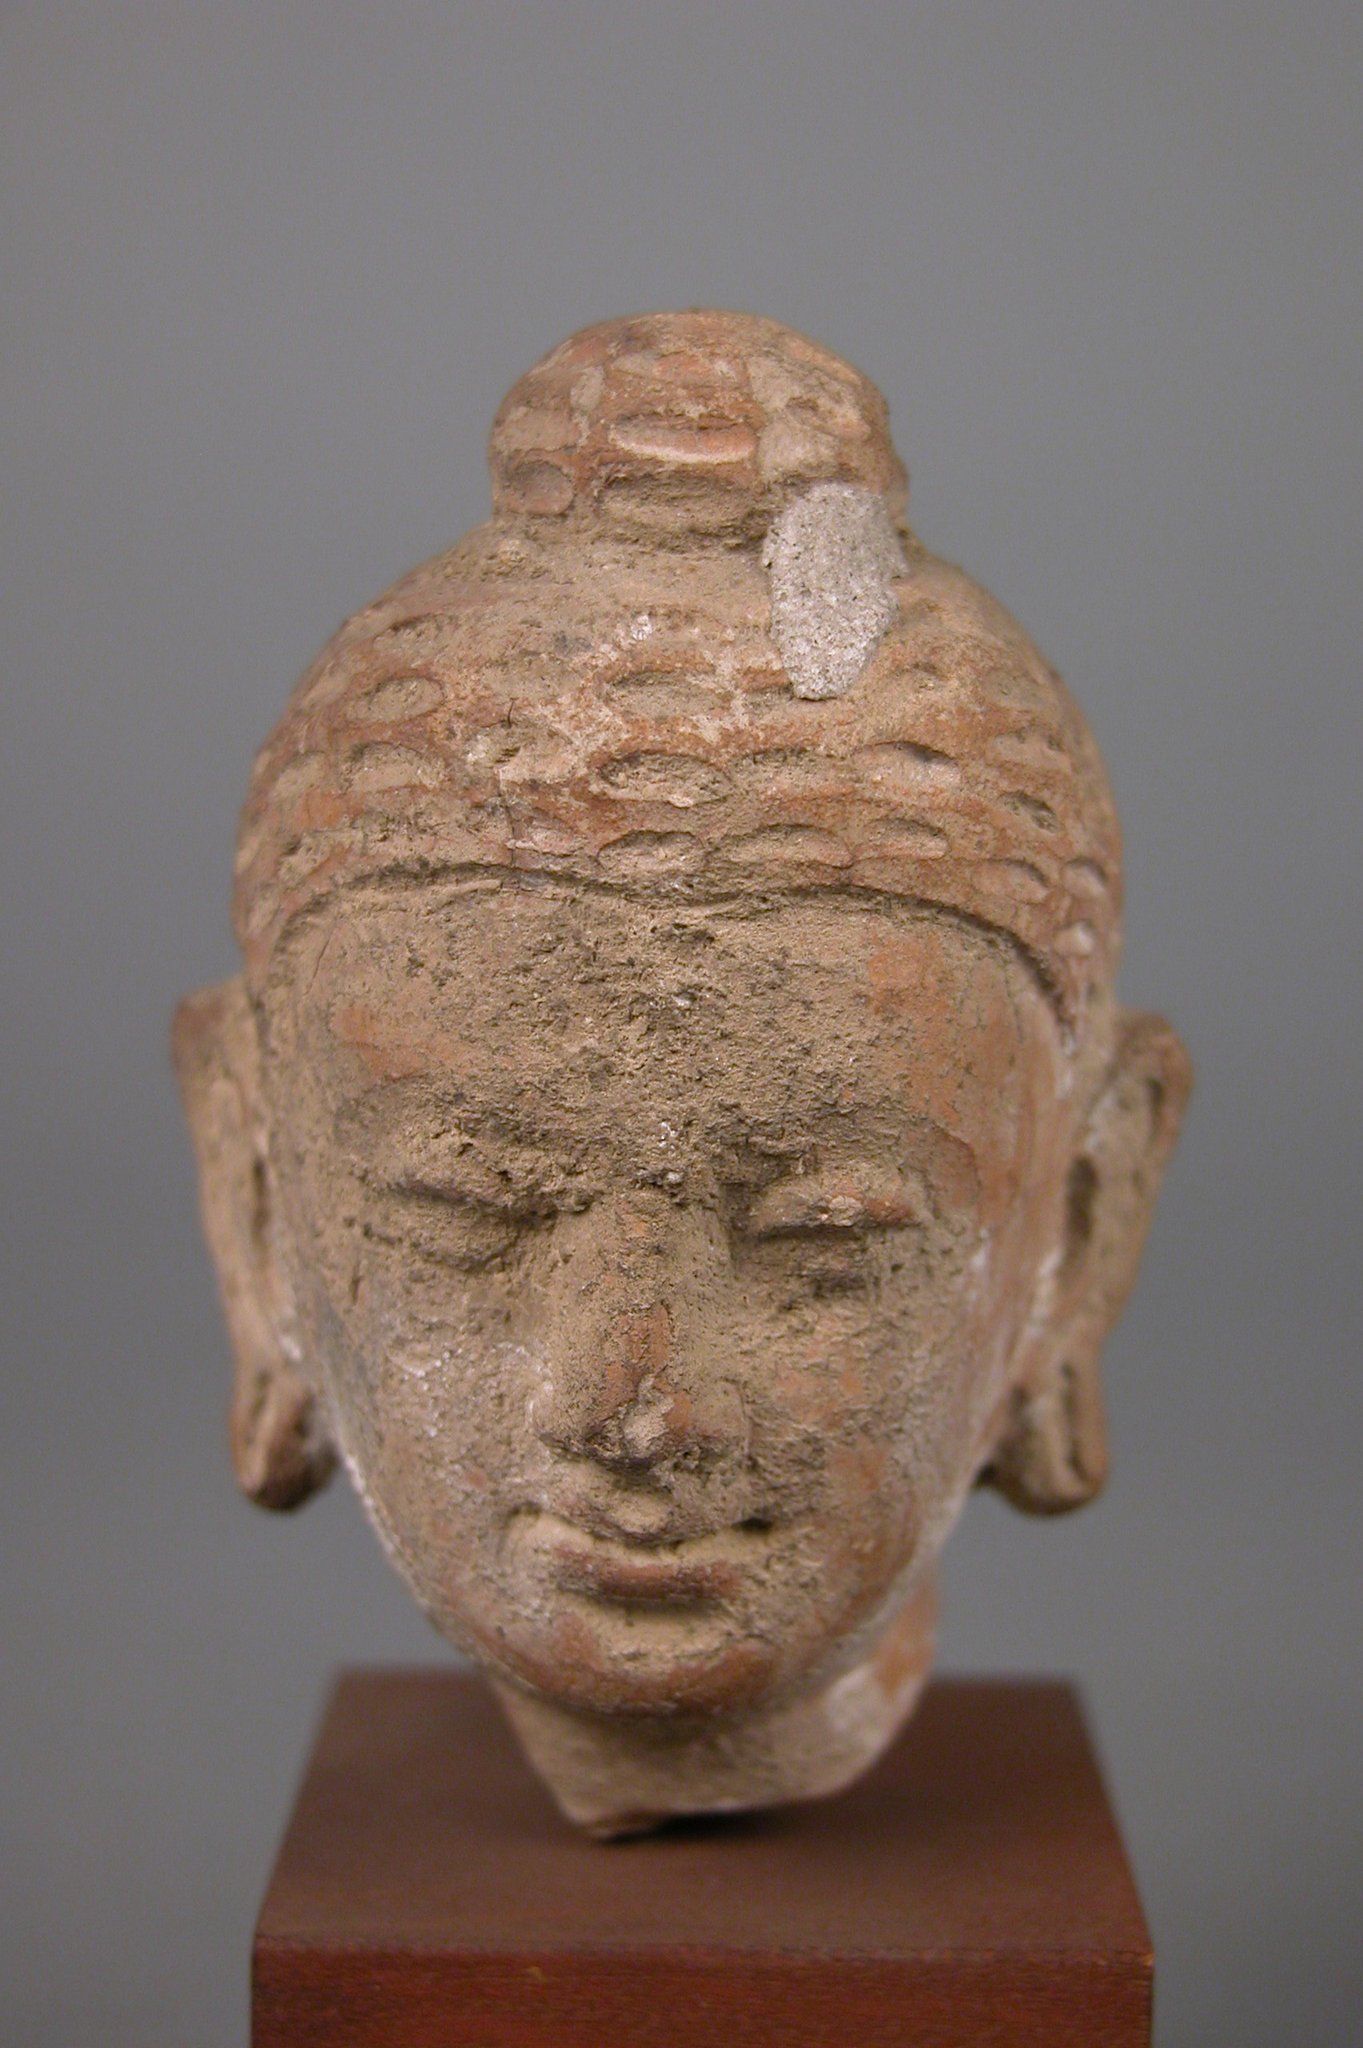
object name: head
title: Head of Buddha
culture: gandhara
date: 301-400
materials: plaster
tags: gandhara,heads,buddhism,buddha